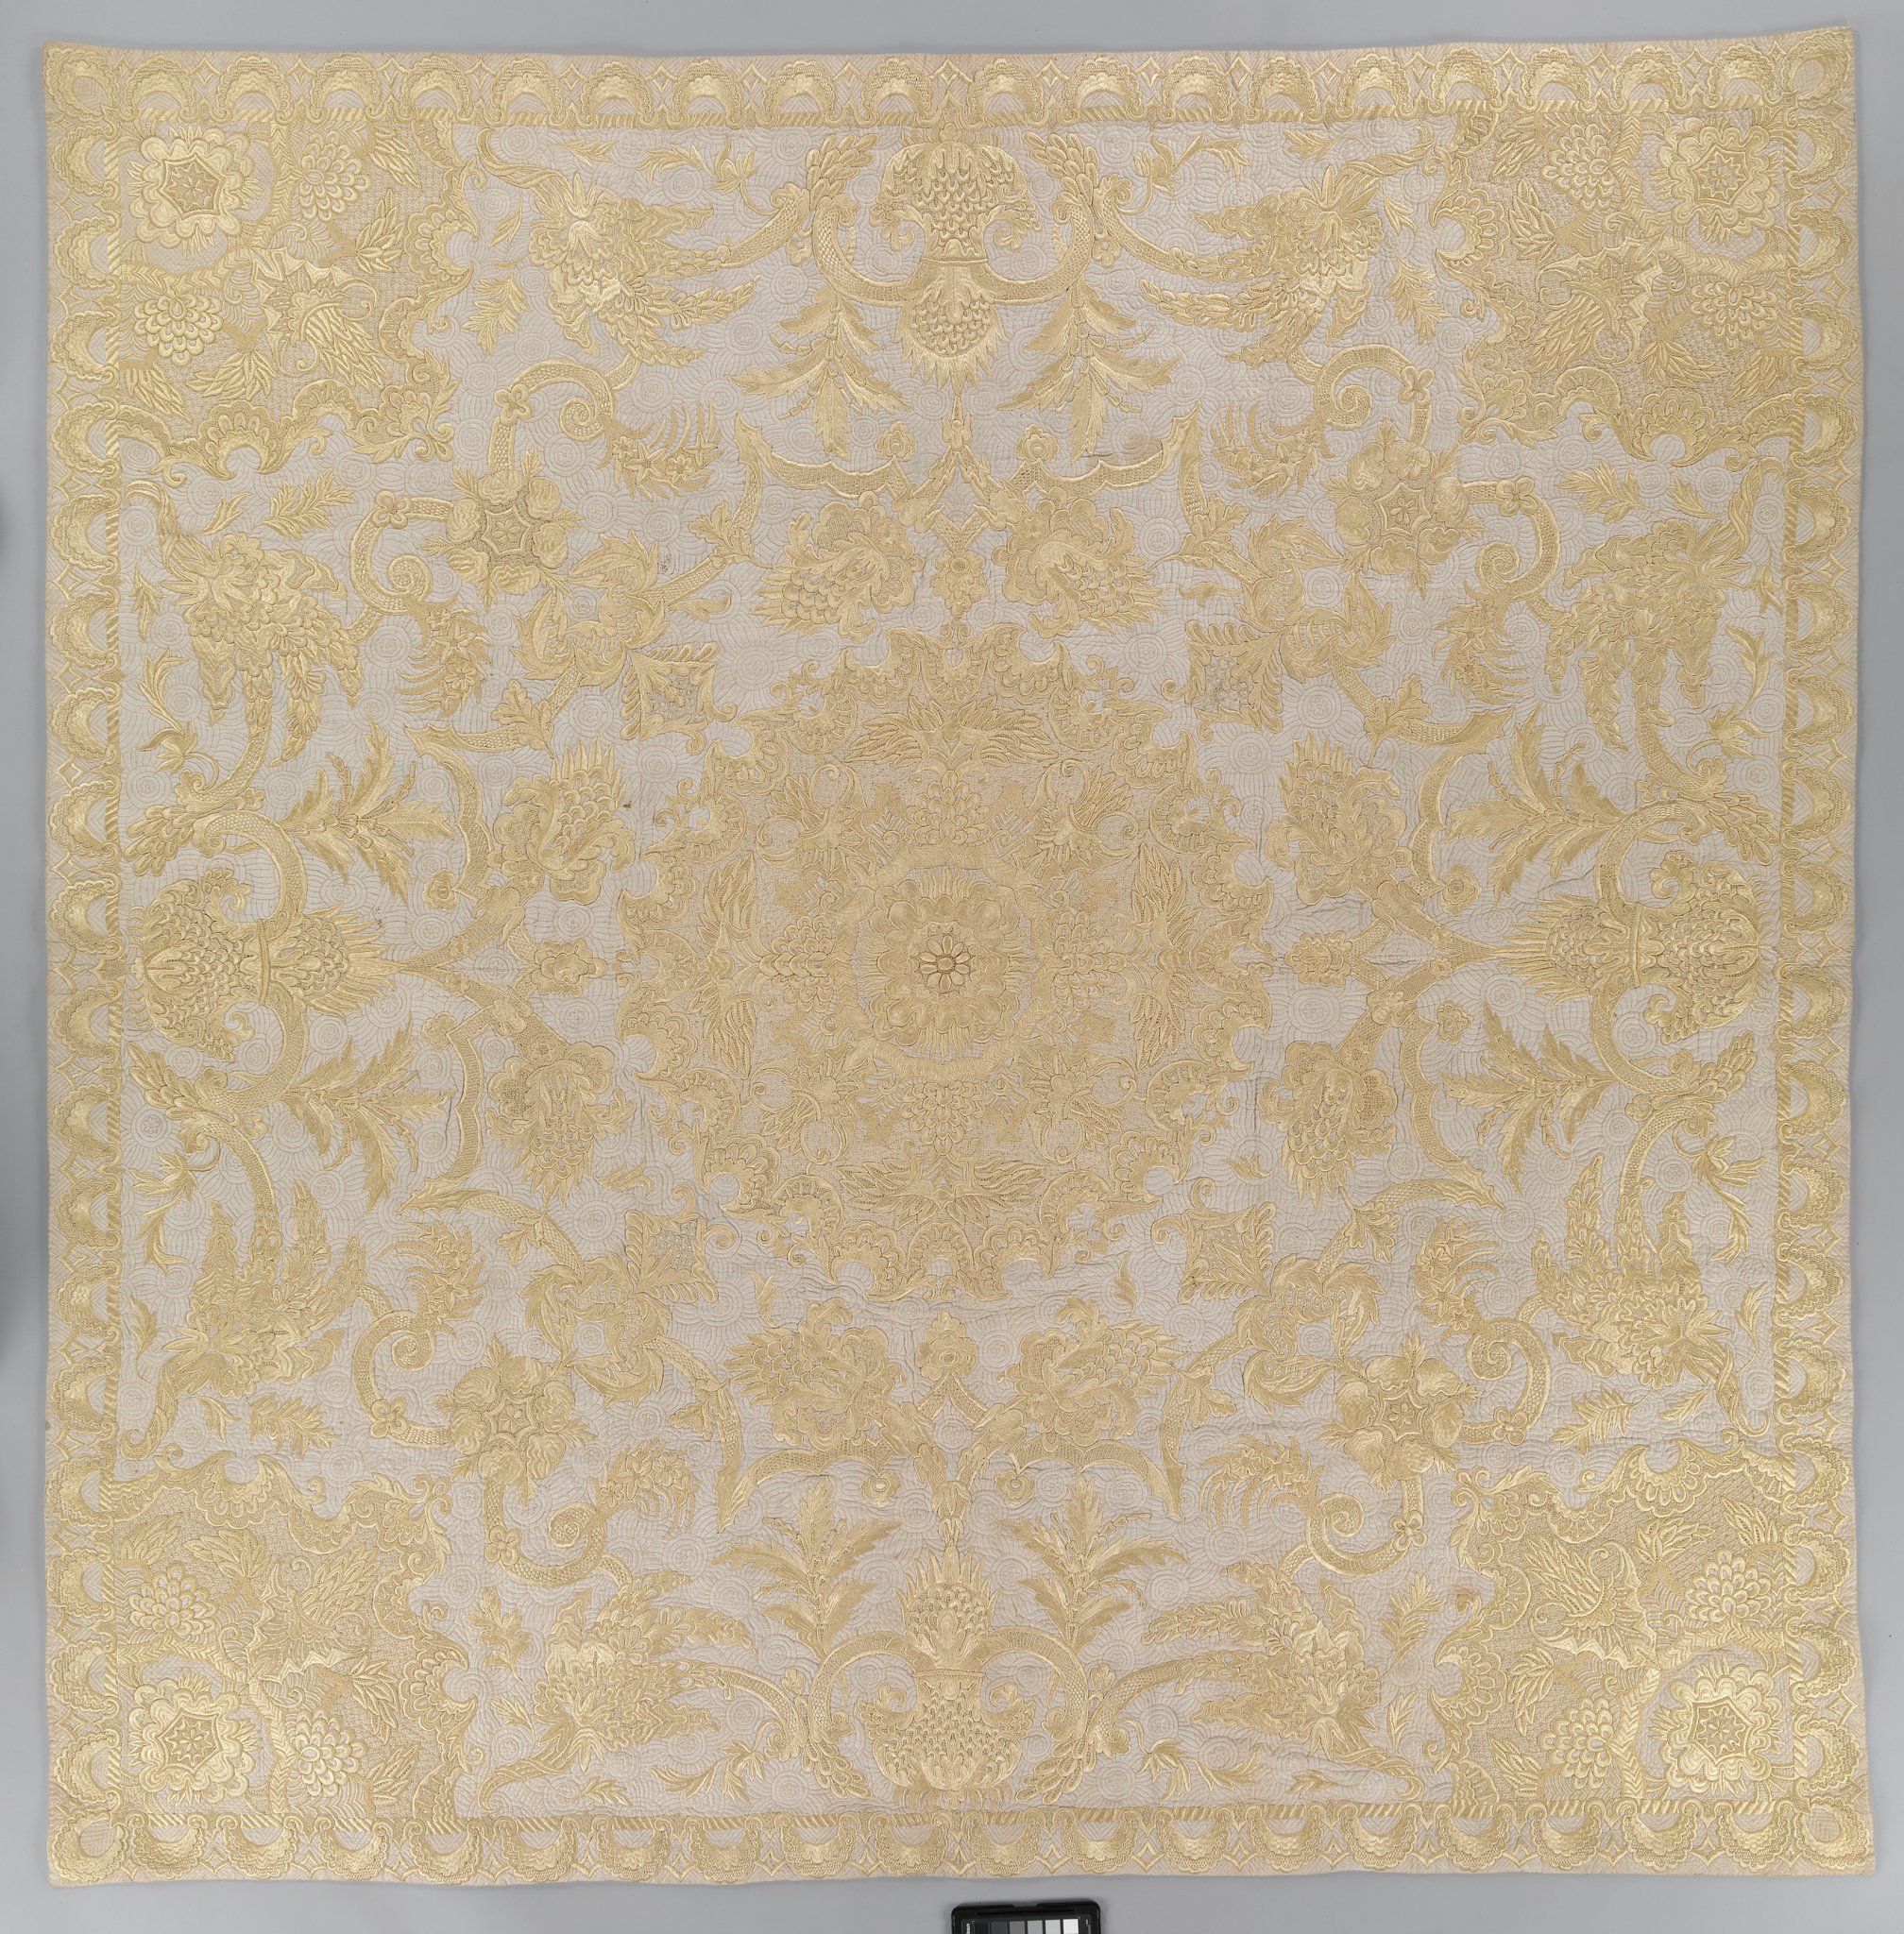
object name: bedspread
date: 1667-1700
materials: cotton, silk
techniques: embroidery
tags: flowers